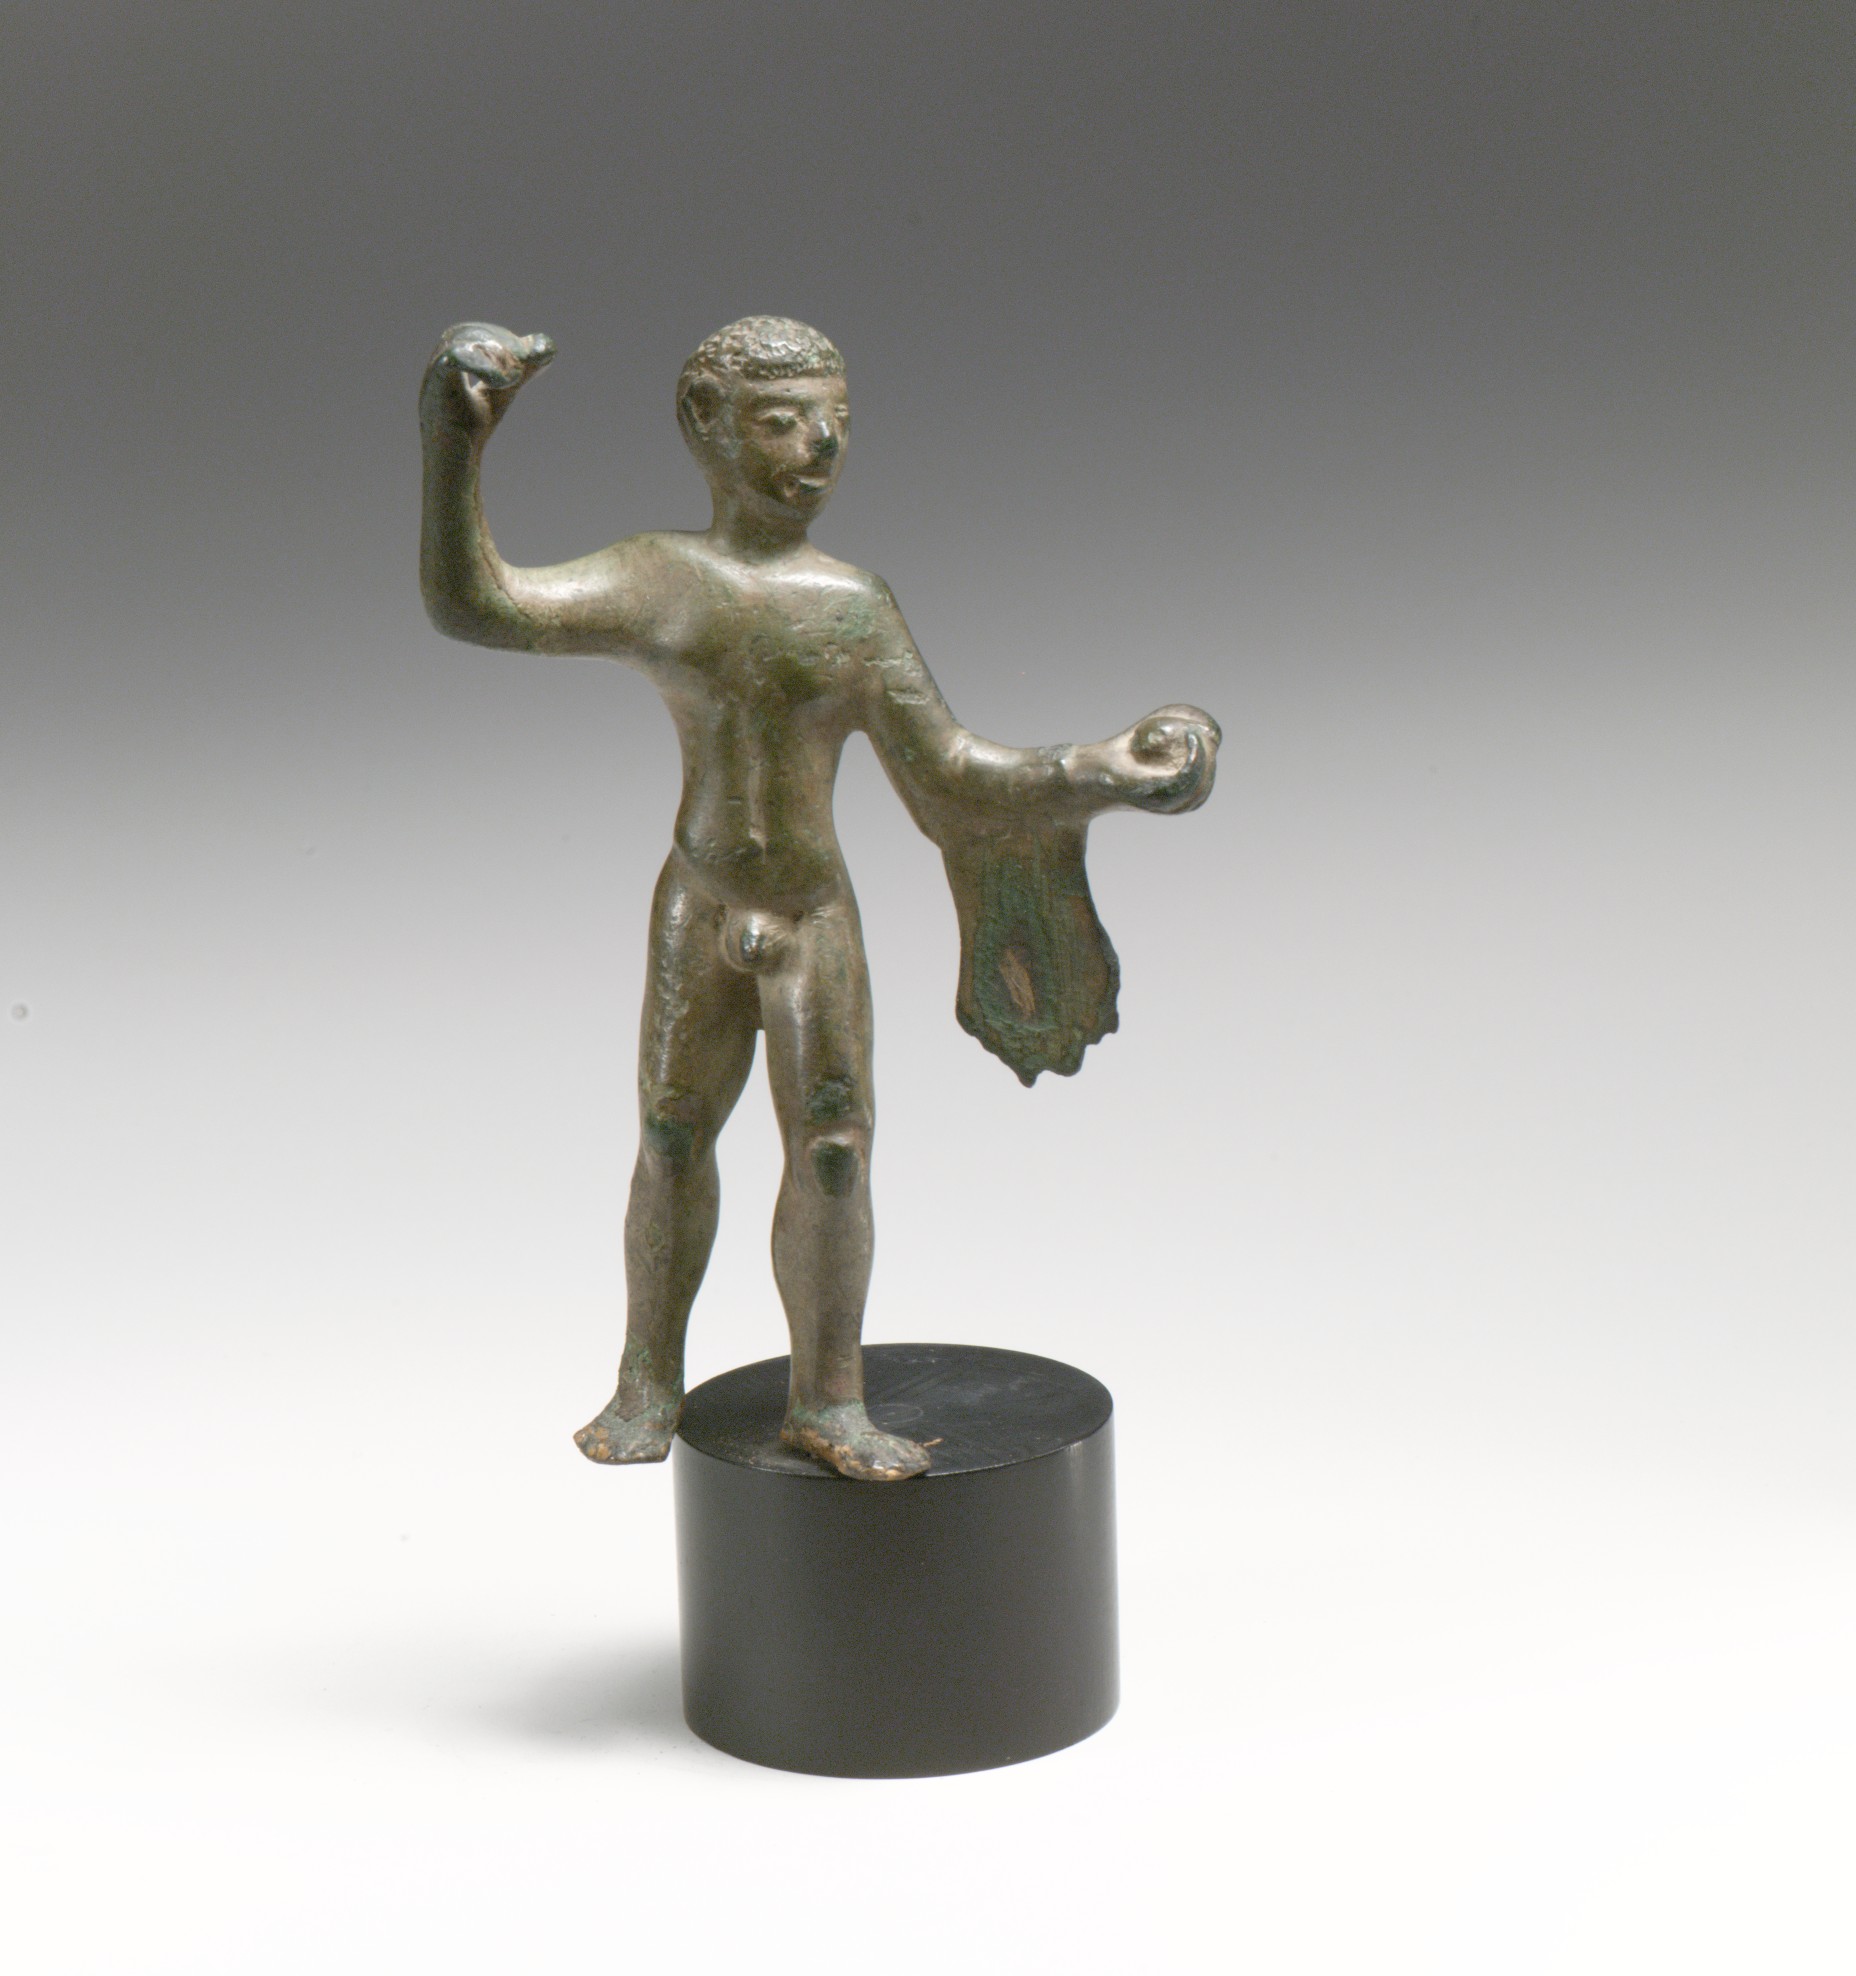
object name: statuette of herakles with round object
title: Bronze statuette of Herakles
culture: italic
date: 300-1 BCE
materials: bronze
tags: herakles